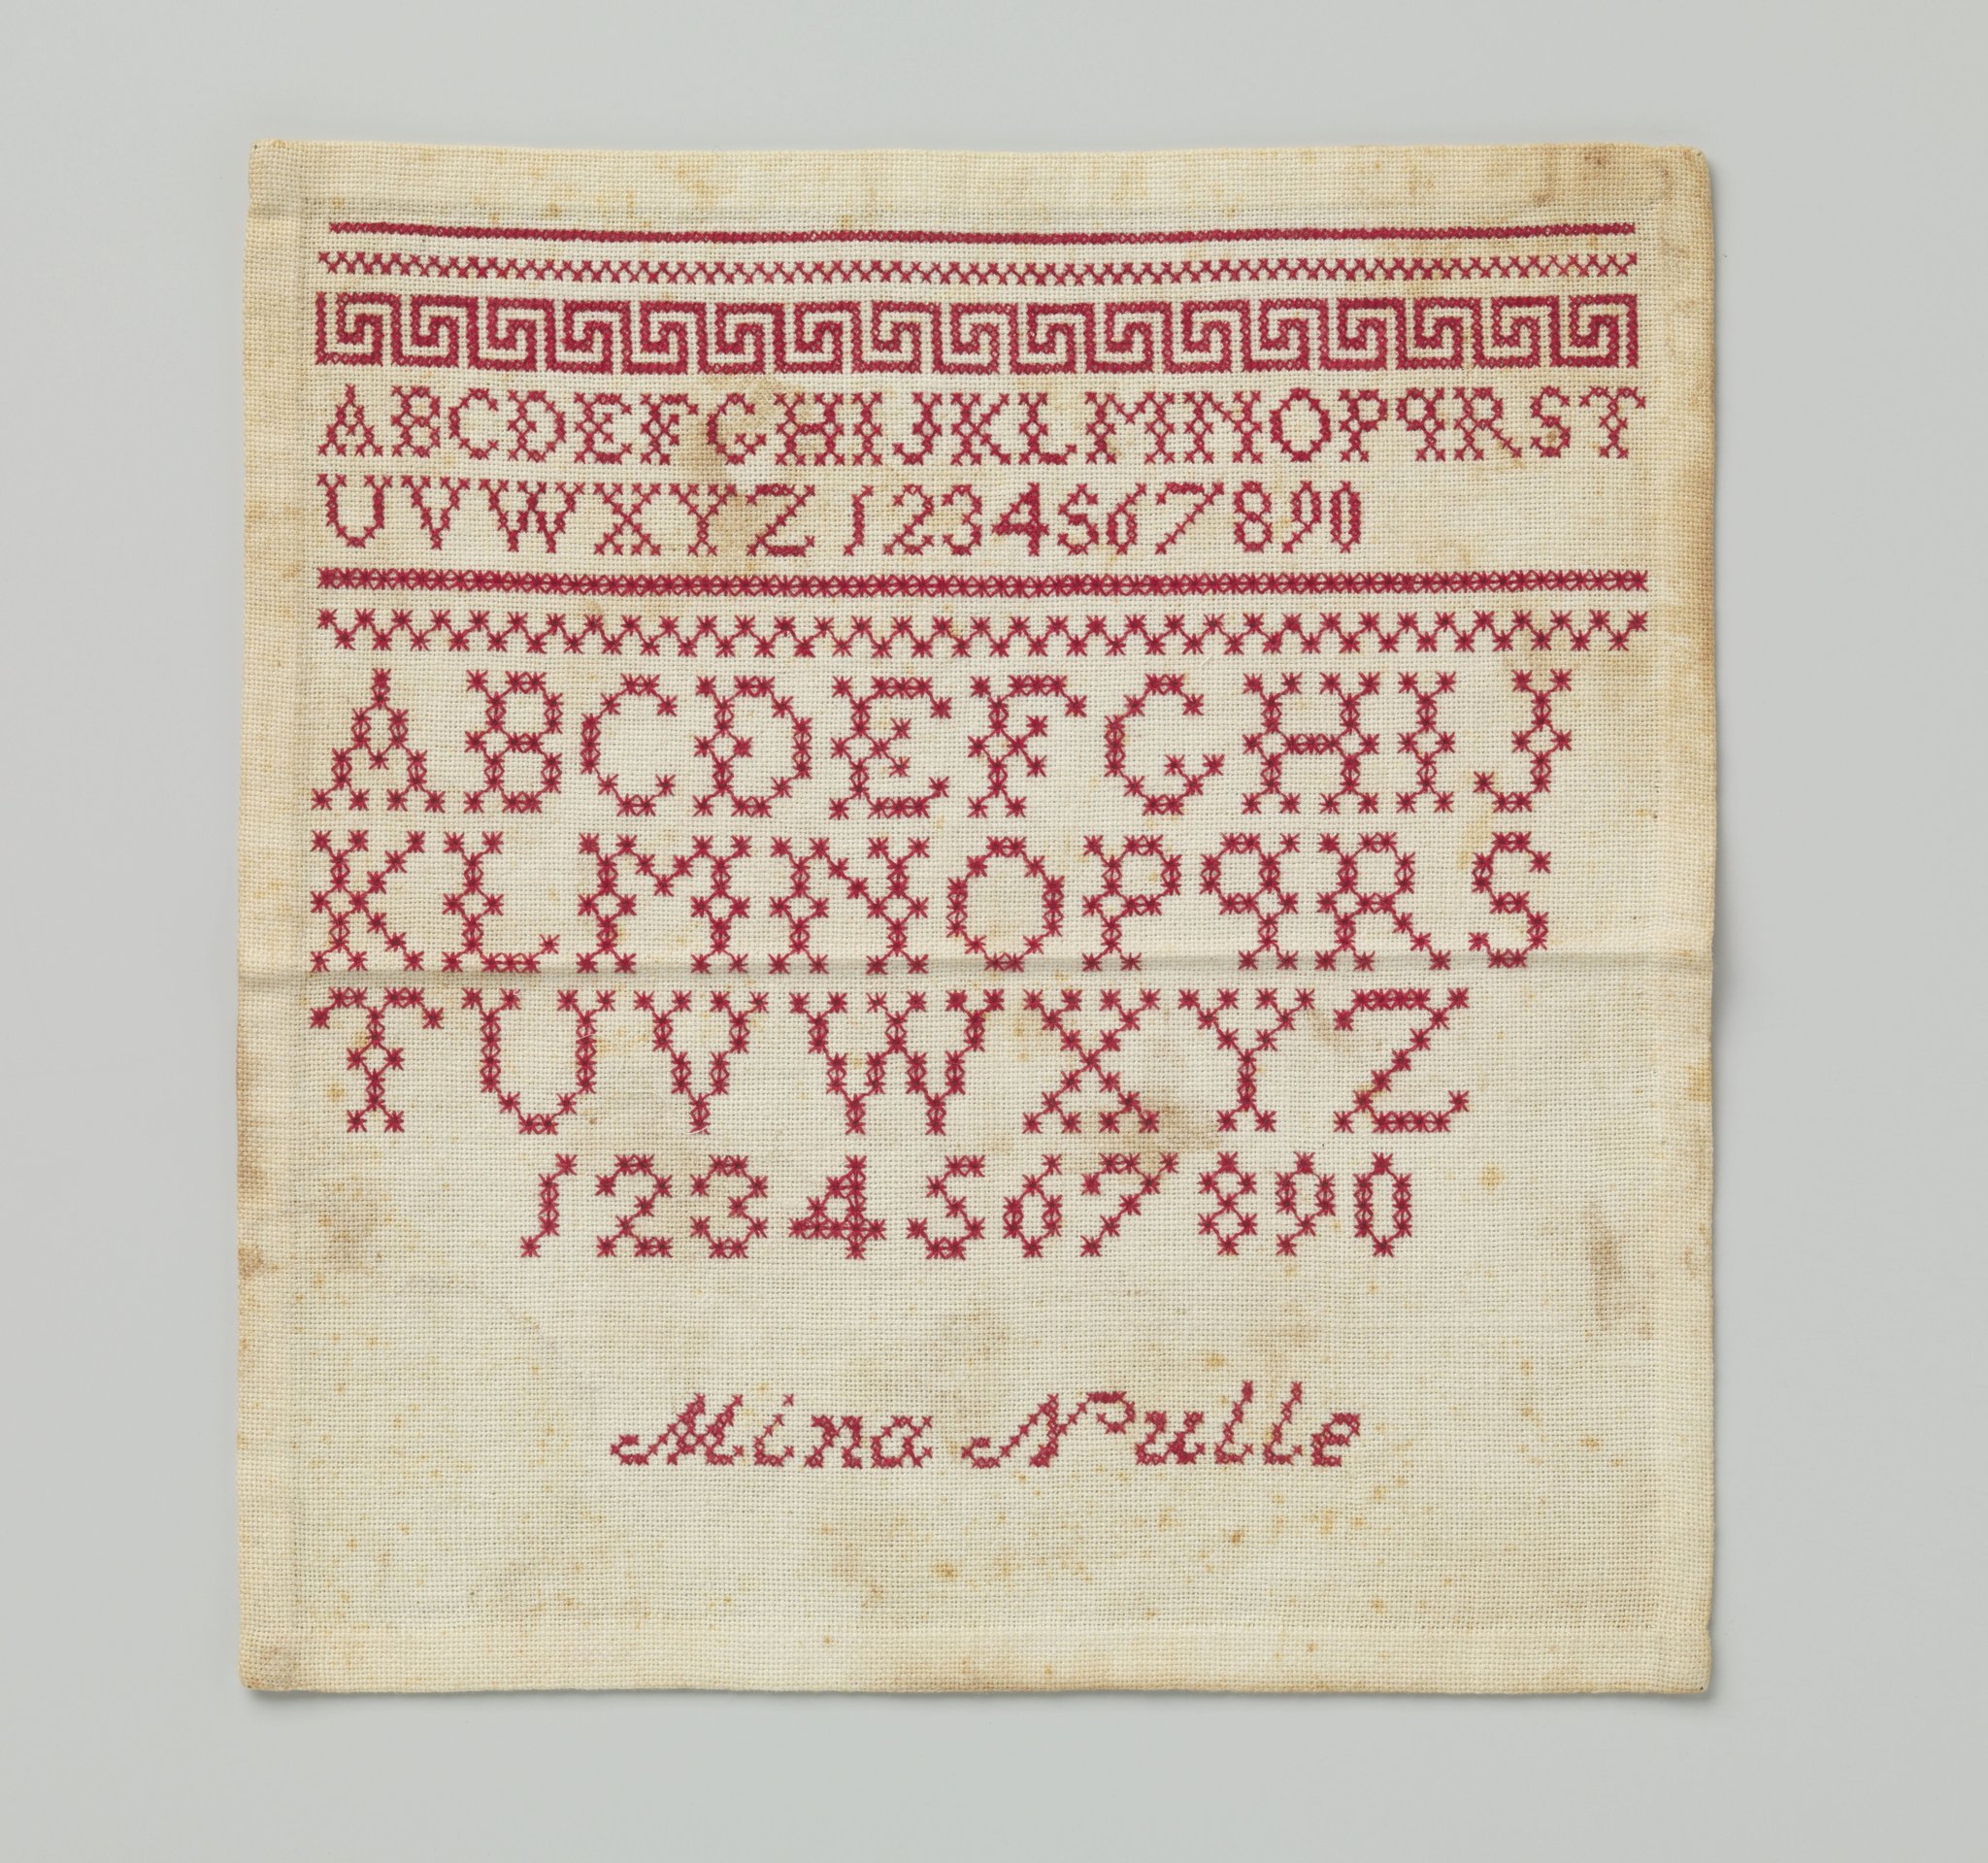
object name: merkdoek, merklap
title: Merklap van rode katoen op katoen.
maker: louise wilhelmina nulle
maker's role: kantwerkster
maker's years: 1884-1982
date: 1900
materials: cotton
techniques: embroidered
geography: netherlands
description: Merklap van katoen op katoen. Het borduurwerk heeft kruisen, verzetskruisen, meanders, een alfabet, cijfers en de naam MINA NULLE.